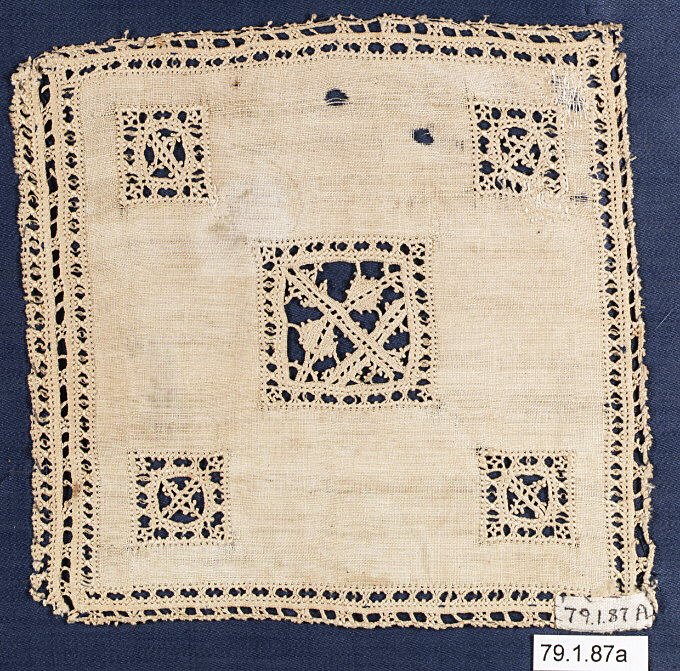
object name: square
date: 1600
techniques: embroidery